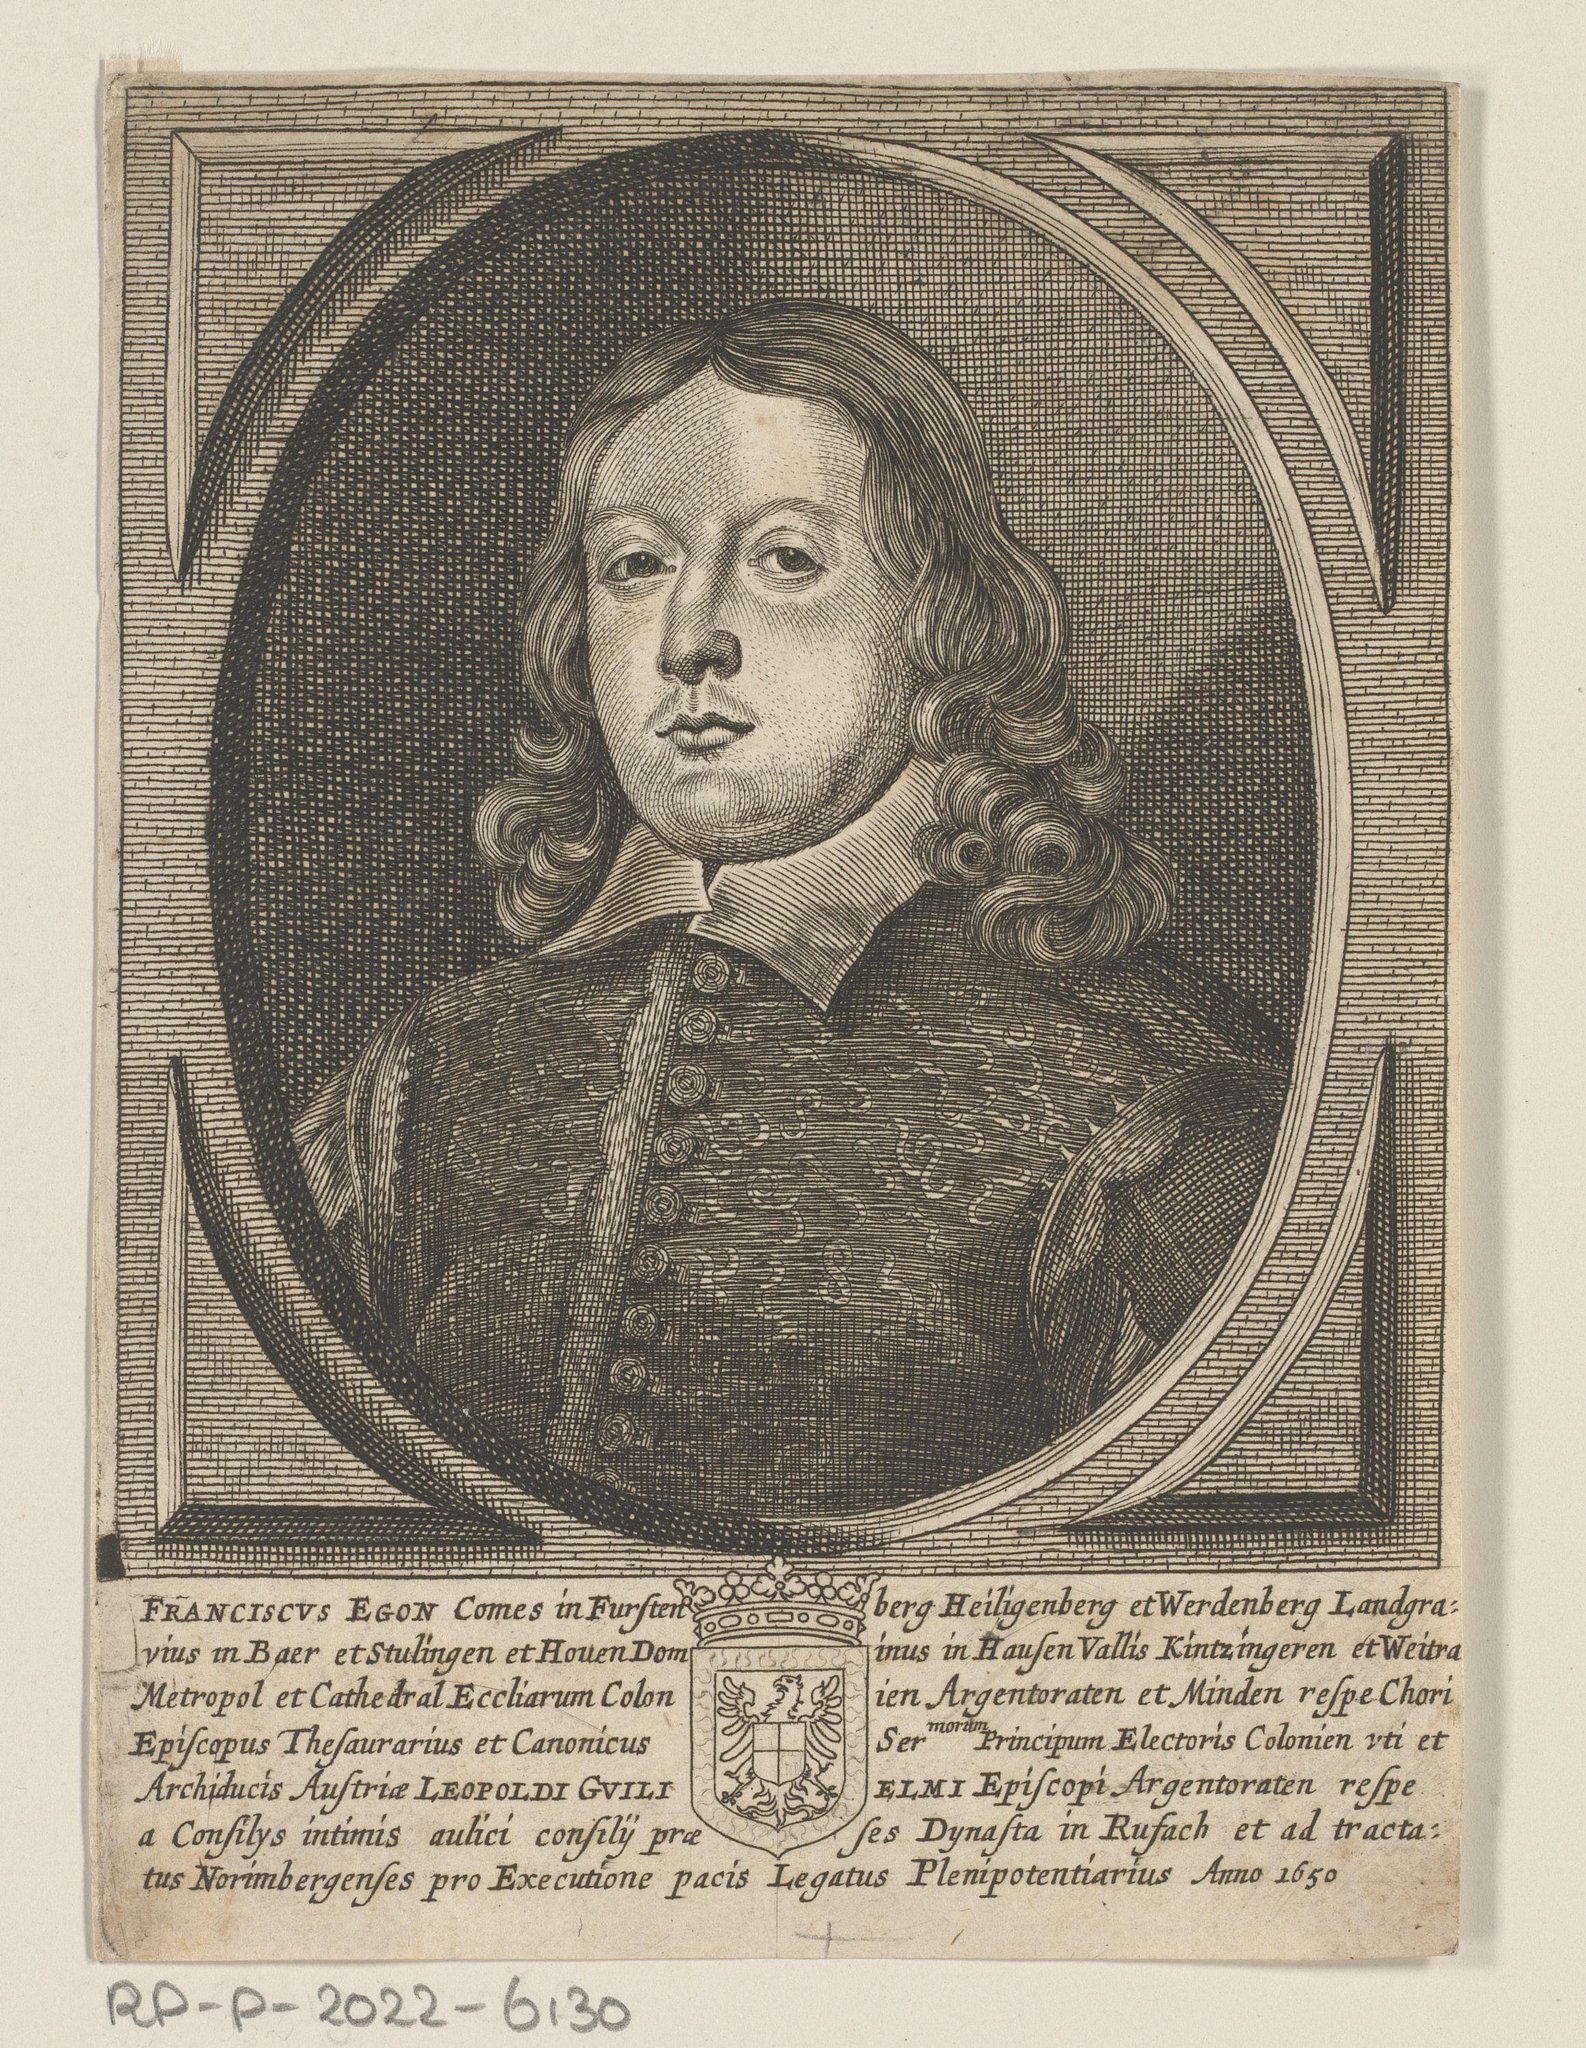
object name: print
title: Portret van Franz Egon von Fürstenberg-Heiligenberg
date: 1650-1670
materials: paper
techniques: engraving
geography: antwerp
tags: cologne, archbishop, bishop, etc. (roman catholic), historical persons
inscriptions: number: ‘22816’, collector's mark: Lugt 2233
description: Met zevenregelig onderschrift in twee kolommen in het Latijn.